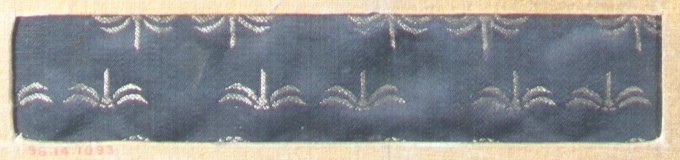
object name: piece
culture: japanese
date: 1701-1900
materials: silk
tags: dragonflies